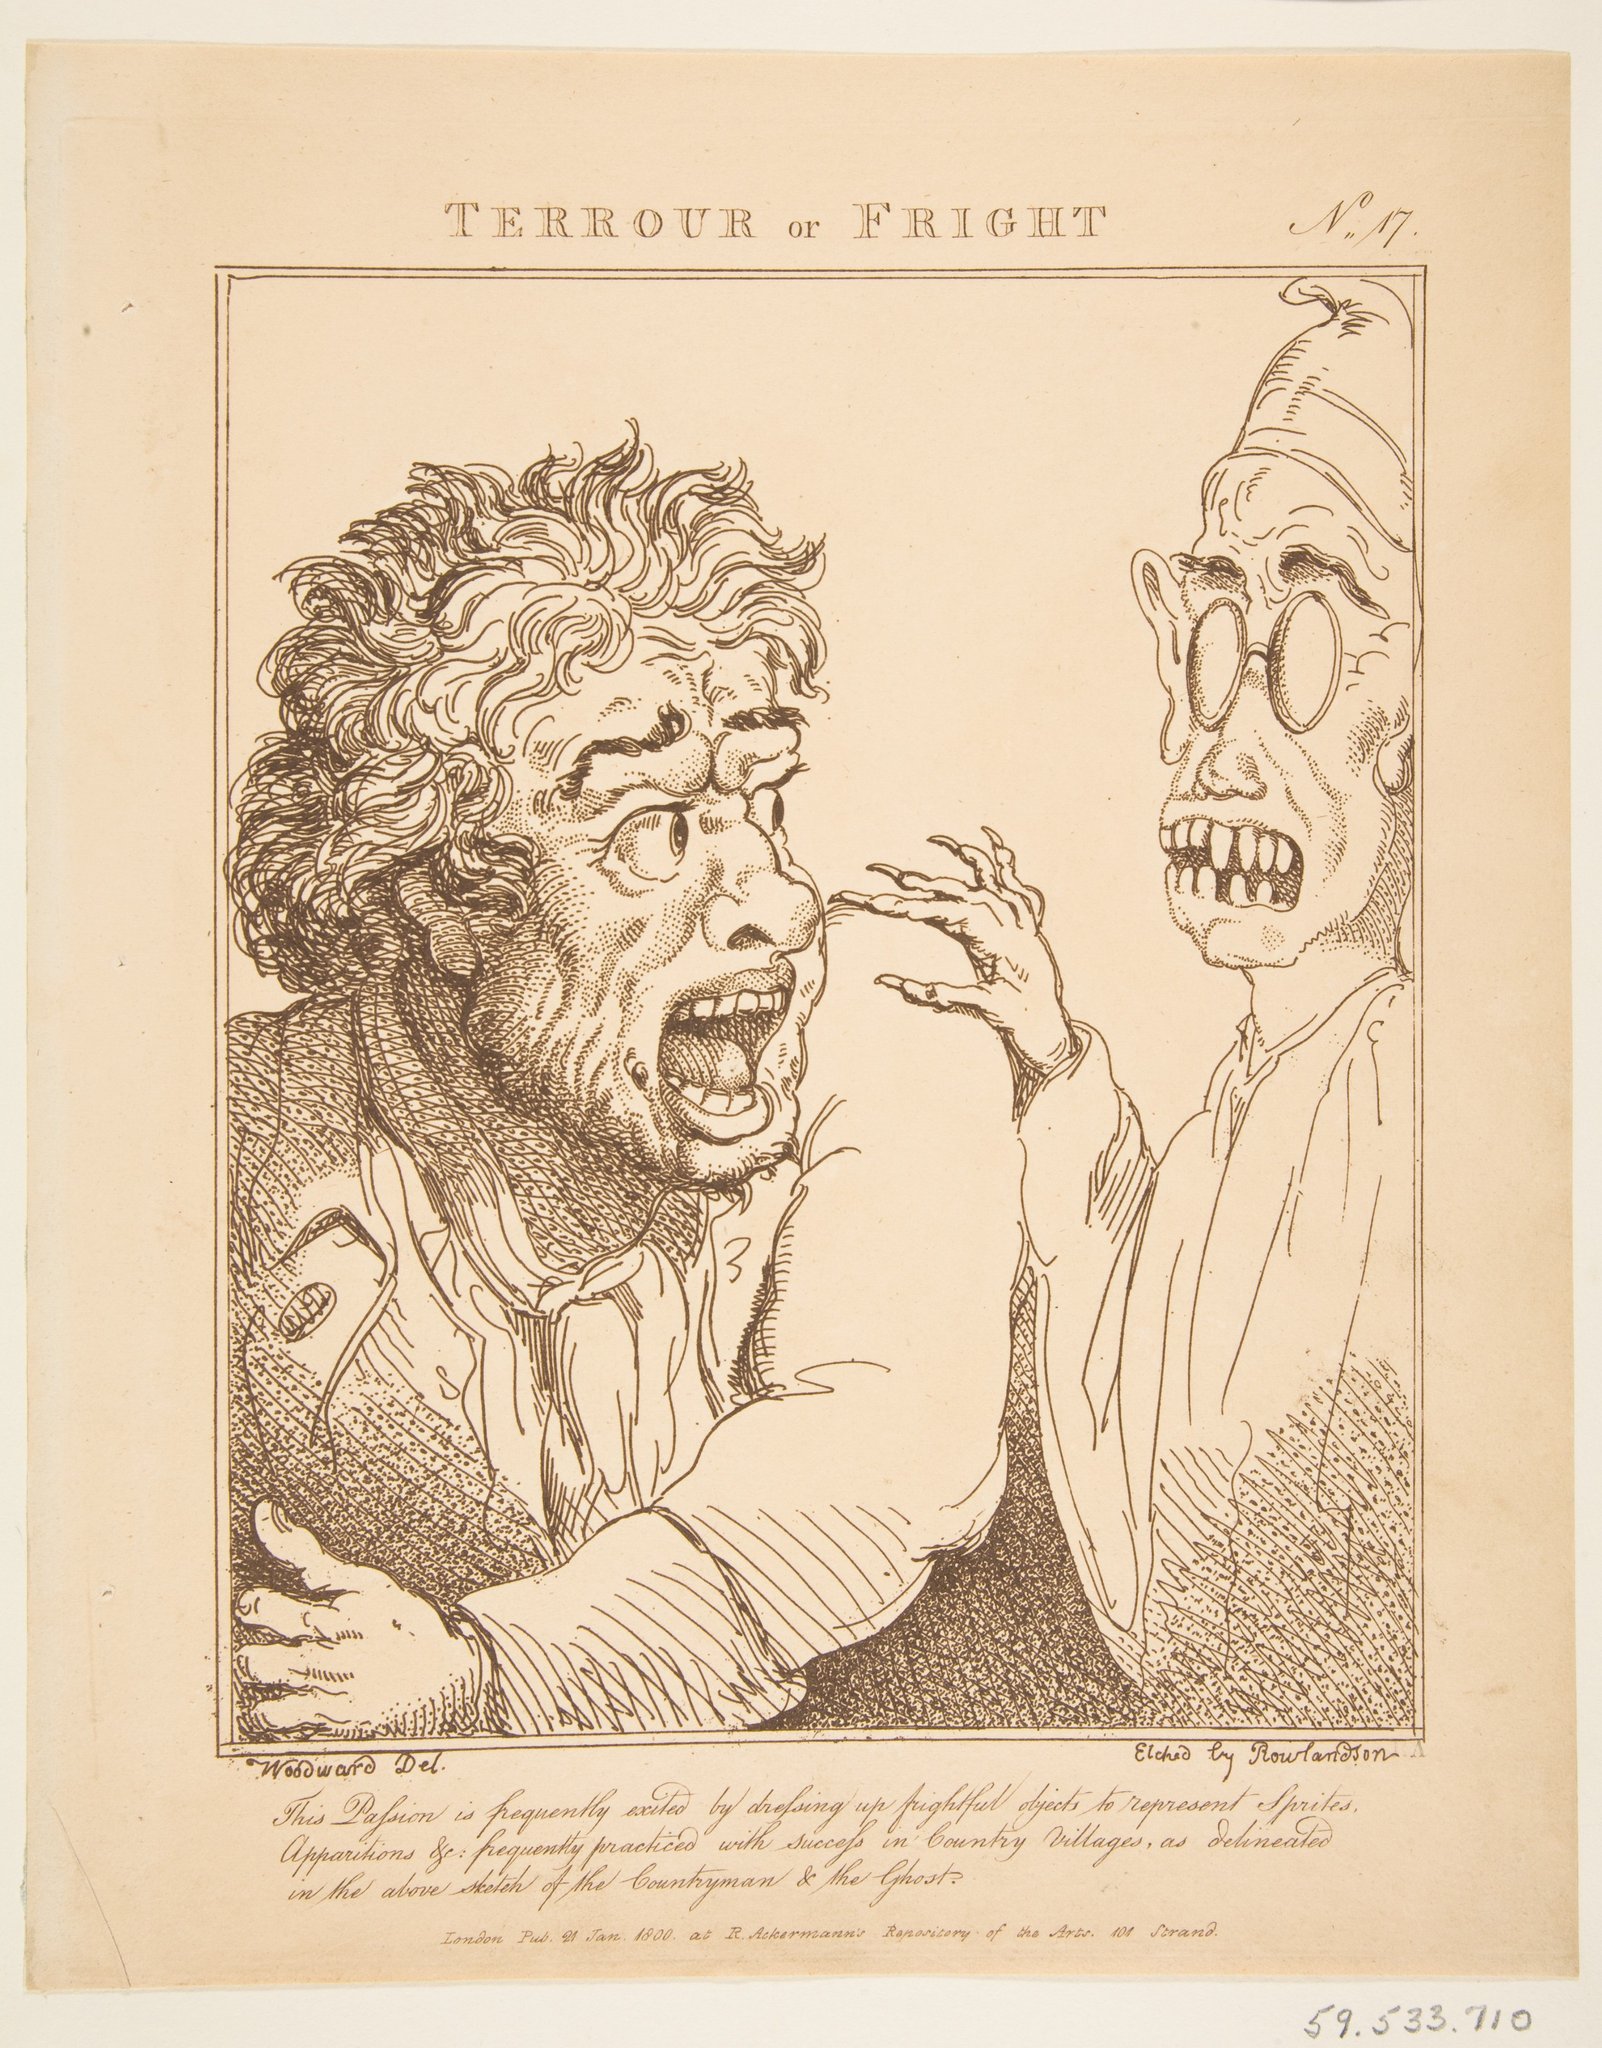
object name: print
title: Terrour or Fright (Le Brun Travested, or Caricatures of the Passions)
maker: thomas rowlandson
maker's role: artist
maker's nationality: british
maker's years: 1757-1827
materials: ink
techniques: etching, printing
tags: fear,men